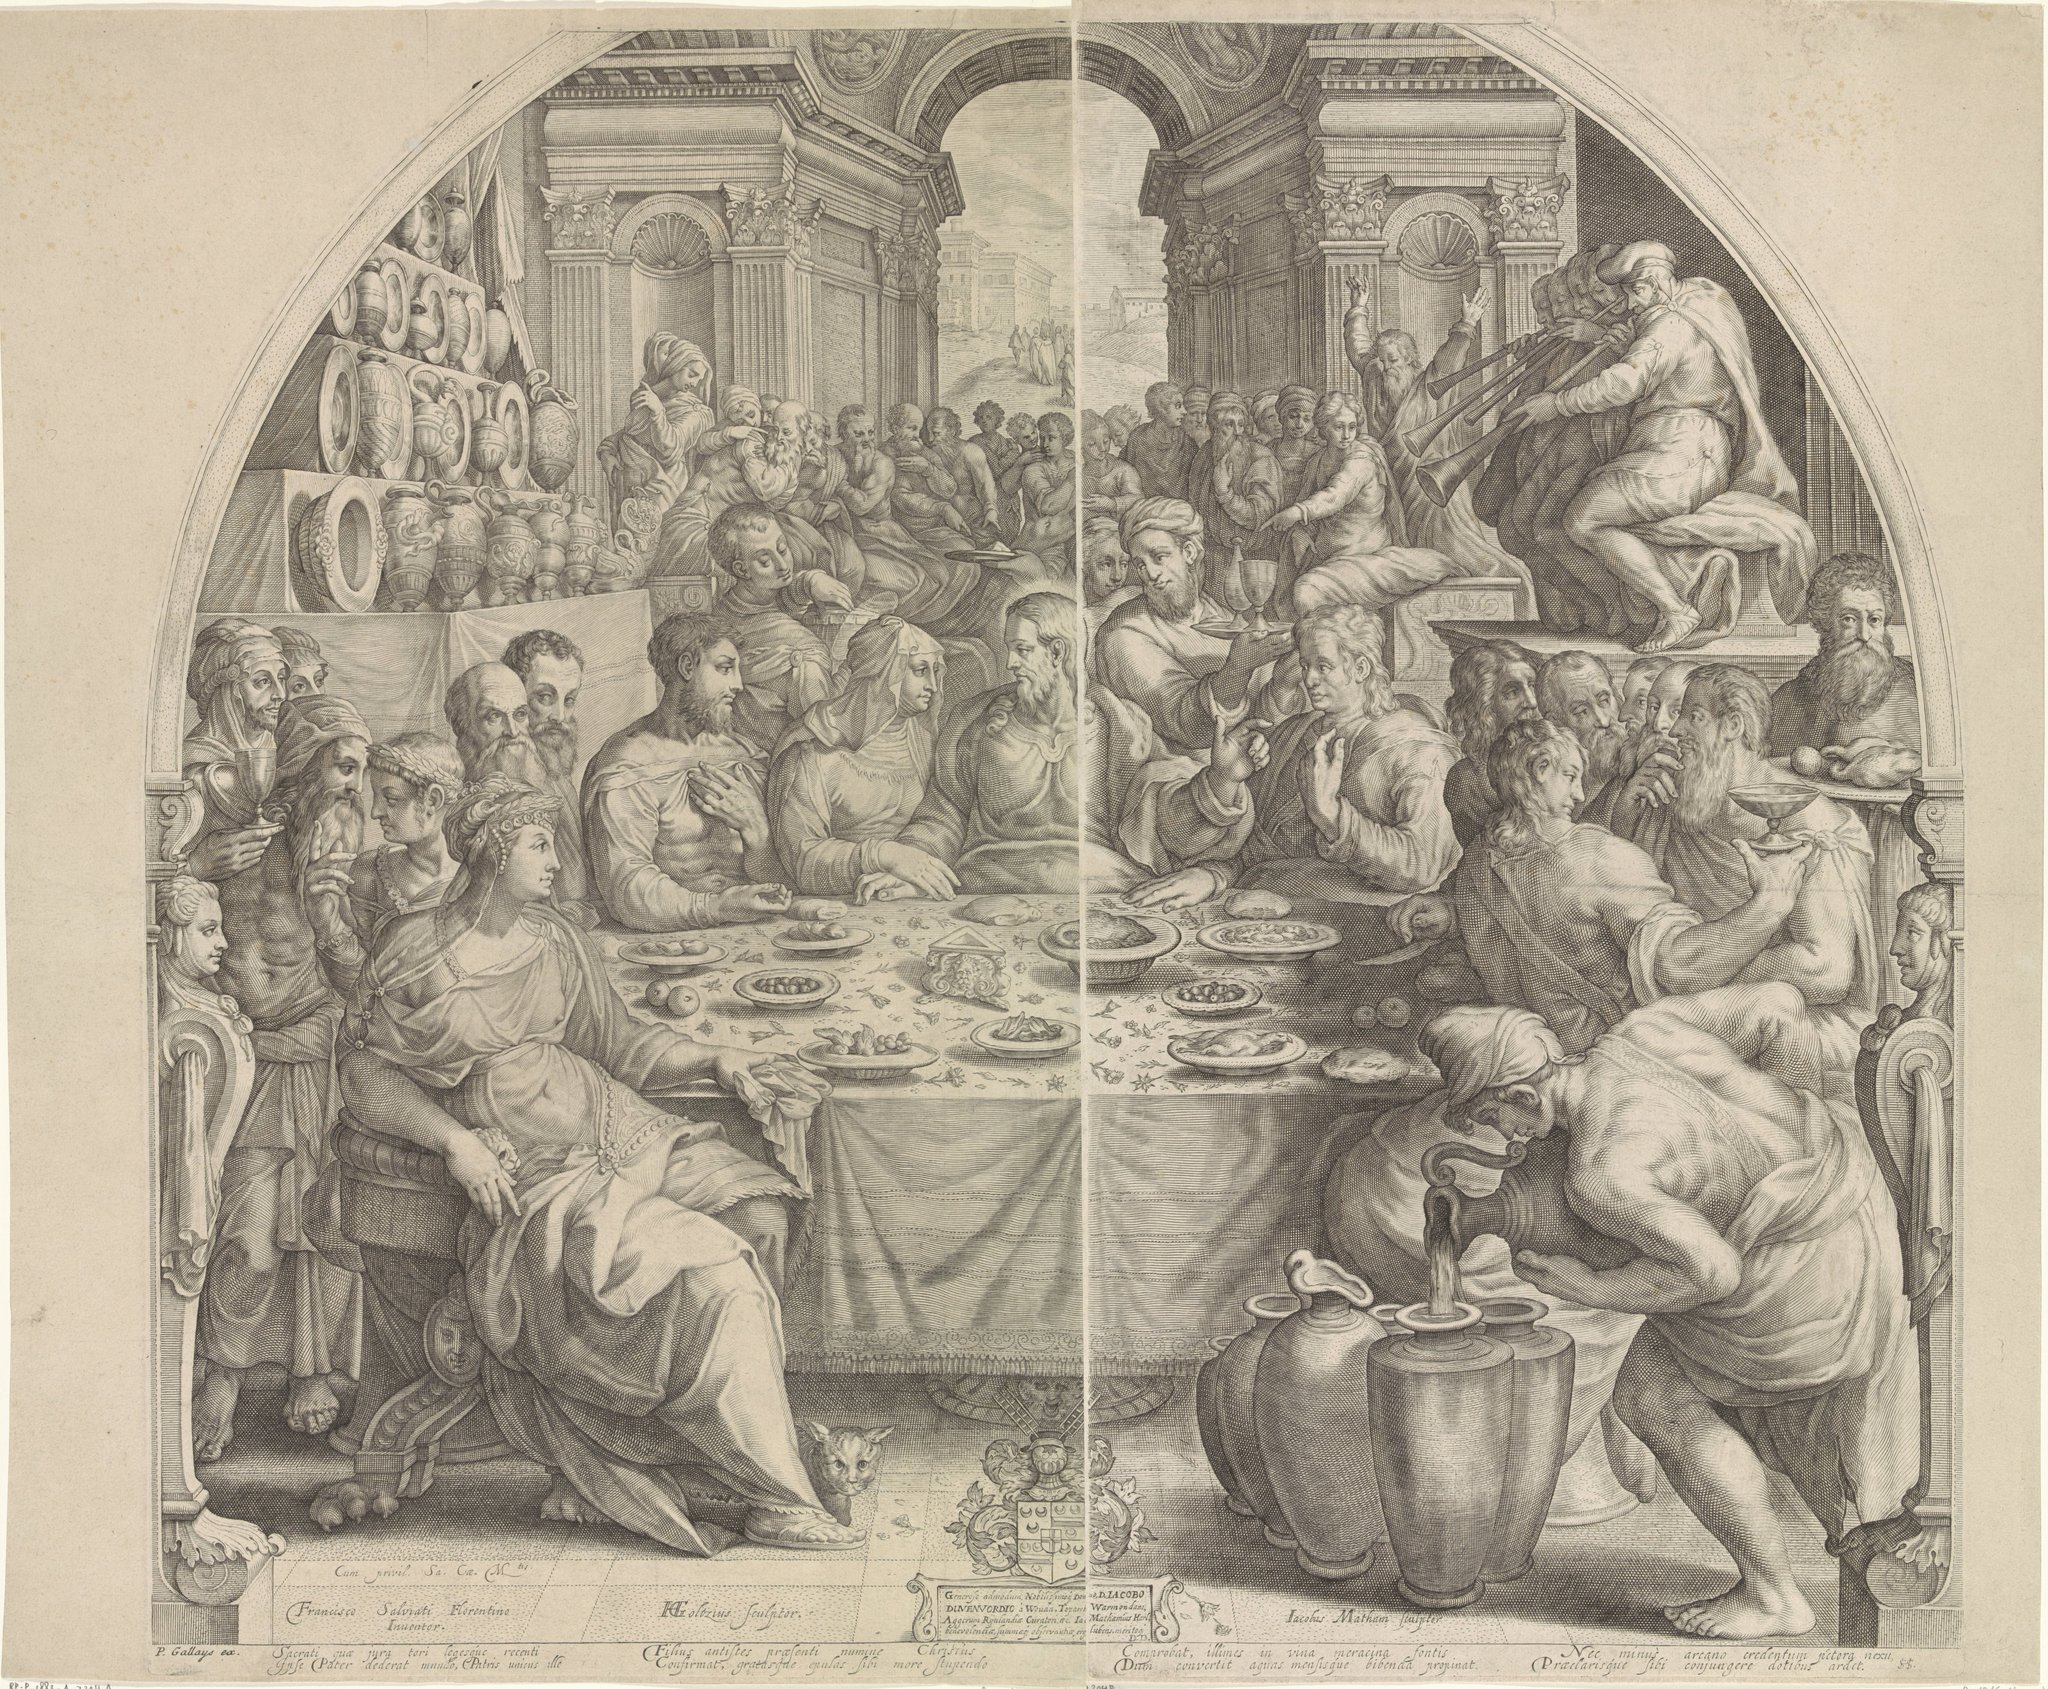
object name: print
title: Bruiloft te Kana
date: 1599-1603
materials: paper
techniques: engraving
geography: paris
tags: the marriage-feast at cana (john 2:1-11), (dinner-)service displayed on sideboard, laid table: table-ware, table-decoration, etc.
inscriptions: collector's mark: Lugt 2228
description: Christus aan een tafel, omringd door vele figuren, tijdens de bruiloft te Kana. Links bespreekt een bediende met de bruidegom dat er geen wijn meer is. Rechts op de voorgrond worden op het verzoek van Christus zes kruiken met water gevuld, dat zal veranderen in wijn.